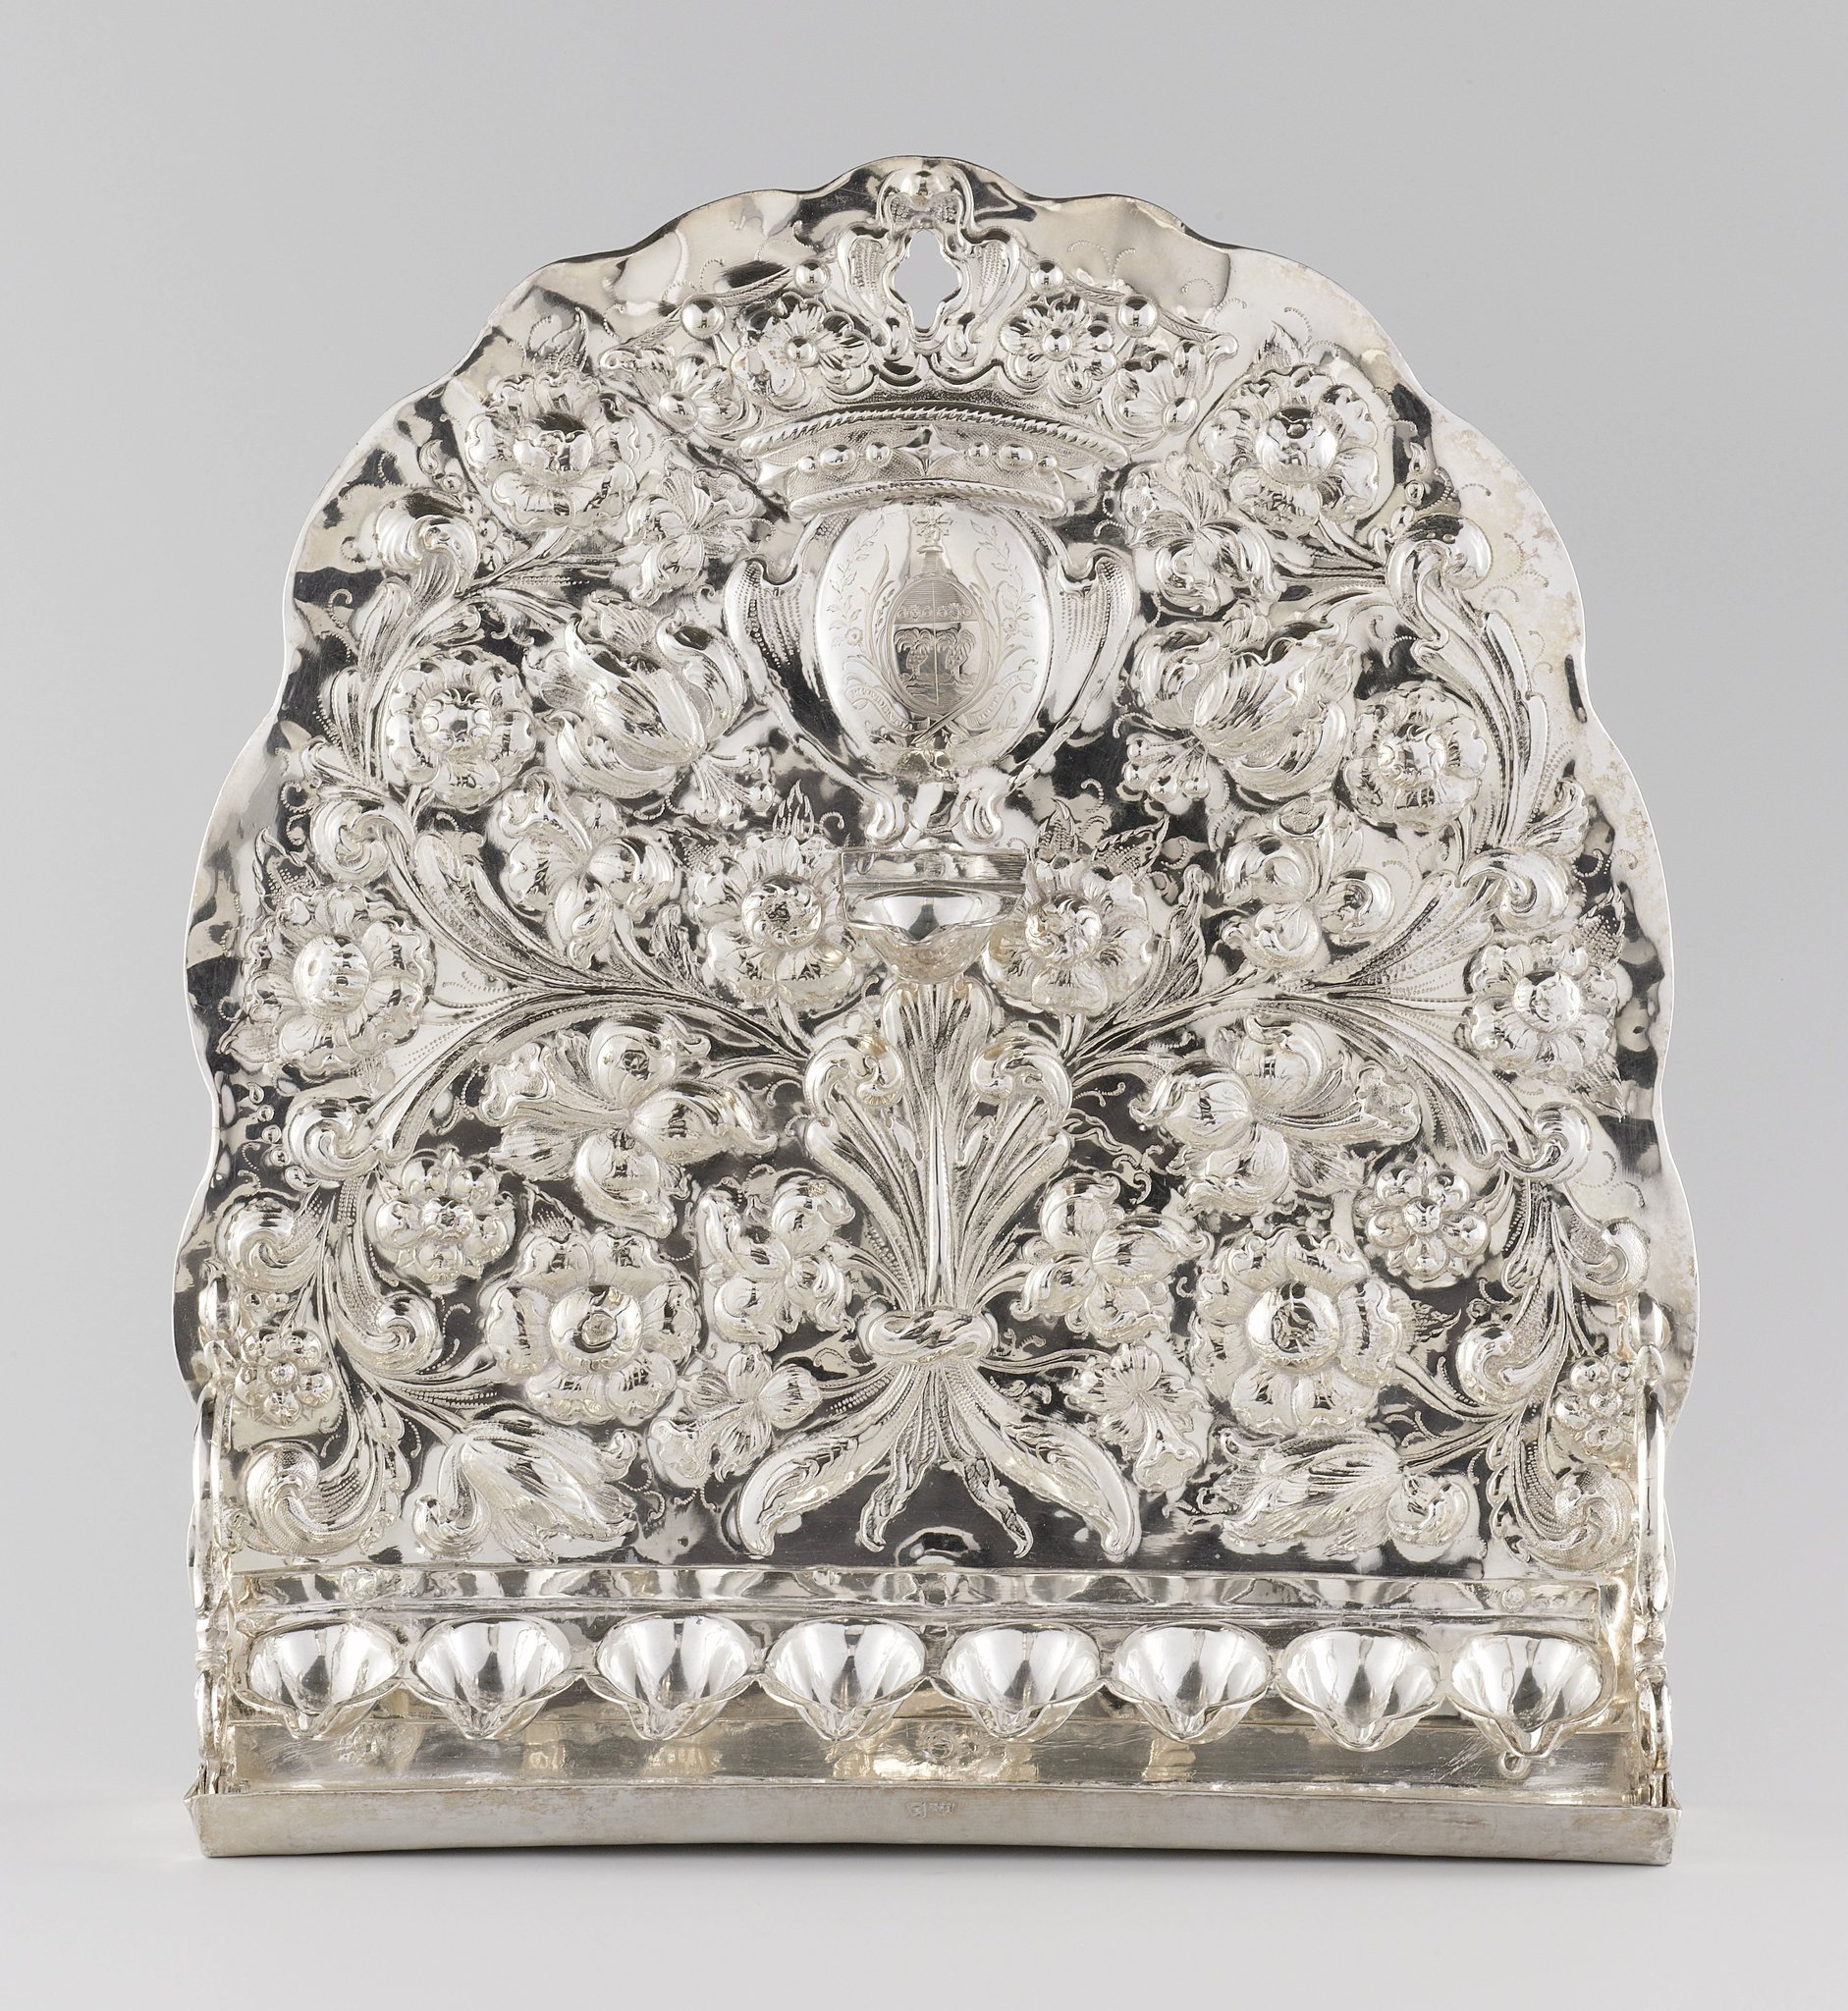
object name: hanukkah lamp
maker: pieter jansz van hoven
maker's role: silversmith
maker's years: 1653-1735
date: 1696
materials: silver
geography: amsterdam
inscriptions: date letter: ‘K’, : ‘gekroonde O (1807)’, : ‘ZII (sedert 1953)’, duty mark: ‘gekroonde V (1814-1853)’, alloy mark: ‘Hollandse leeuw’, maker's mark: ‘VH aaneen in vierkant’, town mark: ‘Amsterdam’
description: Hanukah lamp, silver. Amsterdam, dated 1696, by Pieter van Hoven. Given by the A. Staal company, Amsterdam.